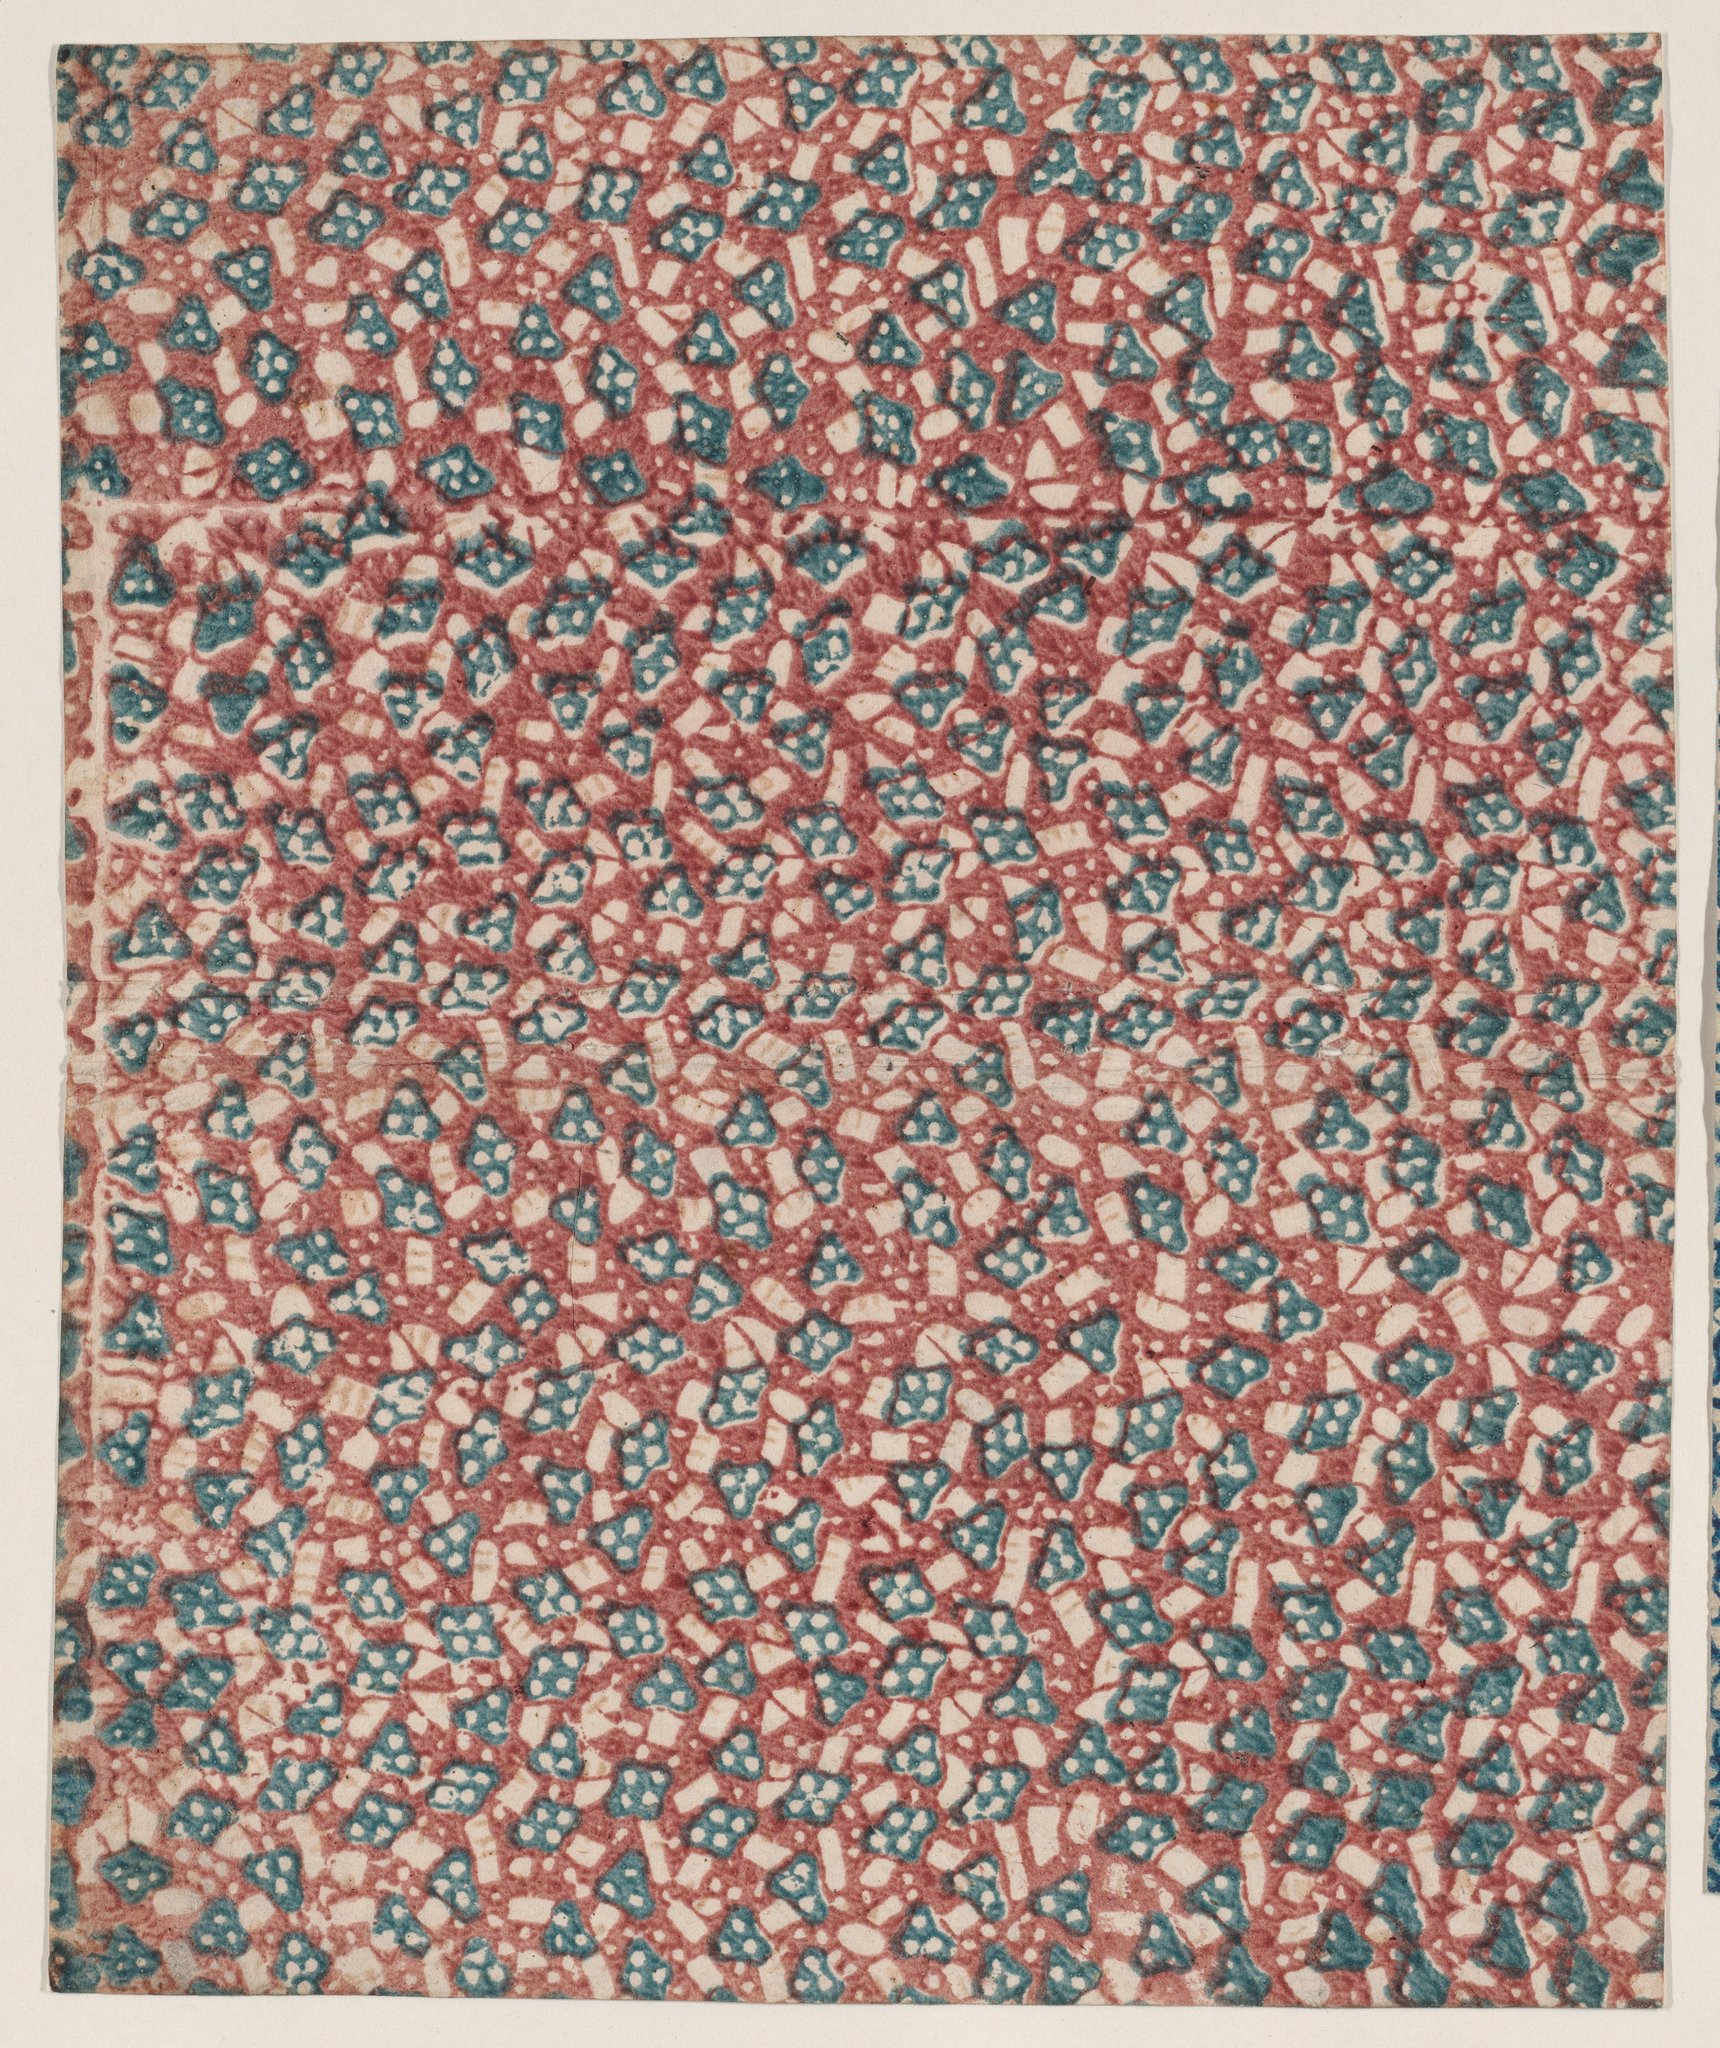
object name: print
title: Sheet with overall abstract pattern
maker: Anonymous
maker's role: artist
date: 1801-1900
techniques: relief print